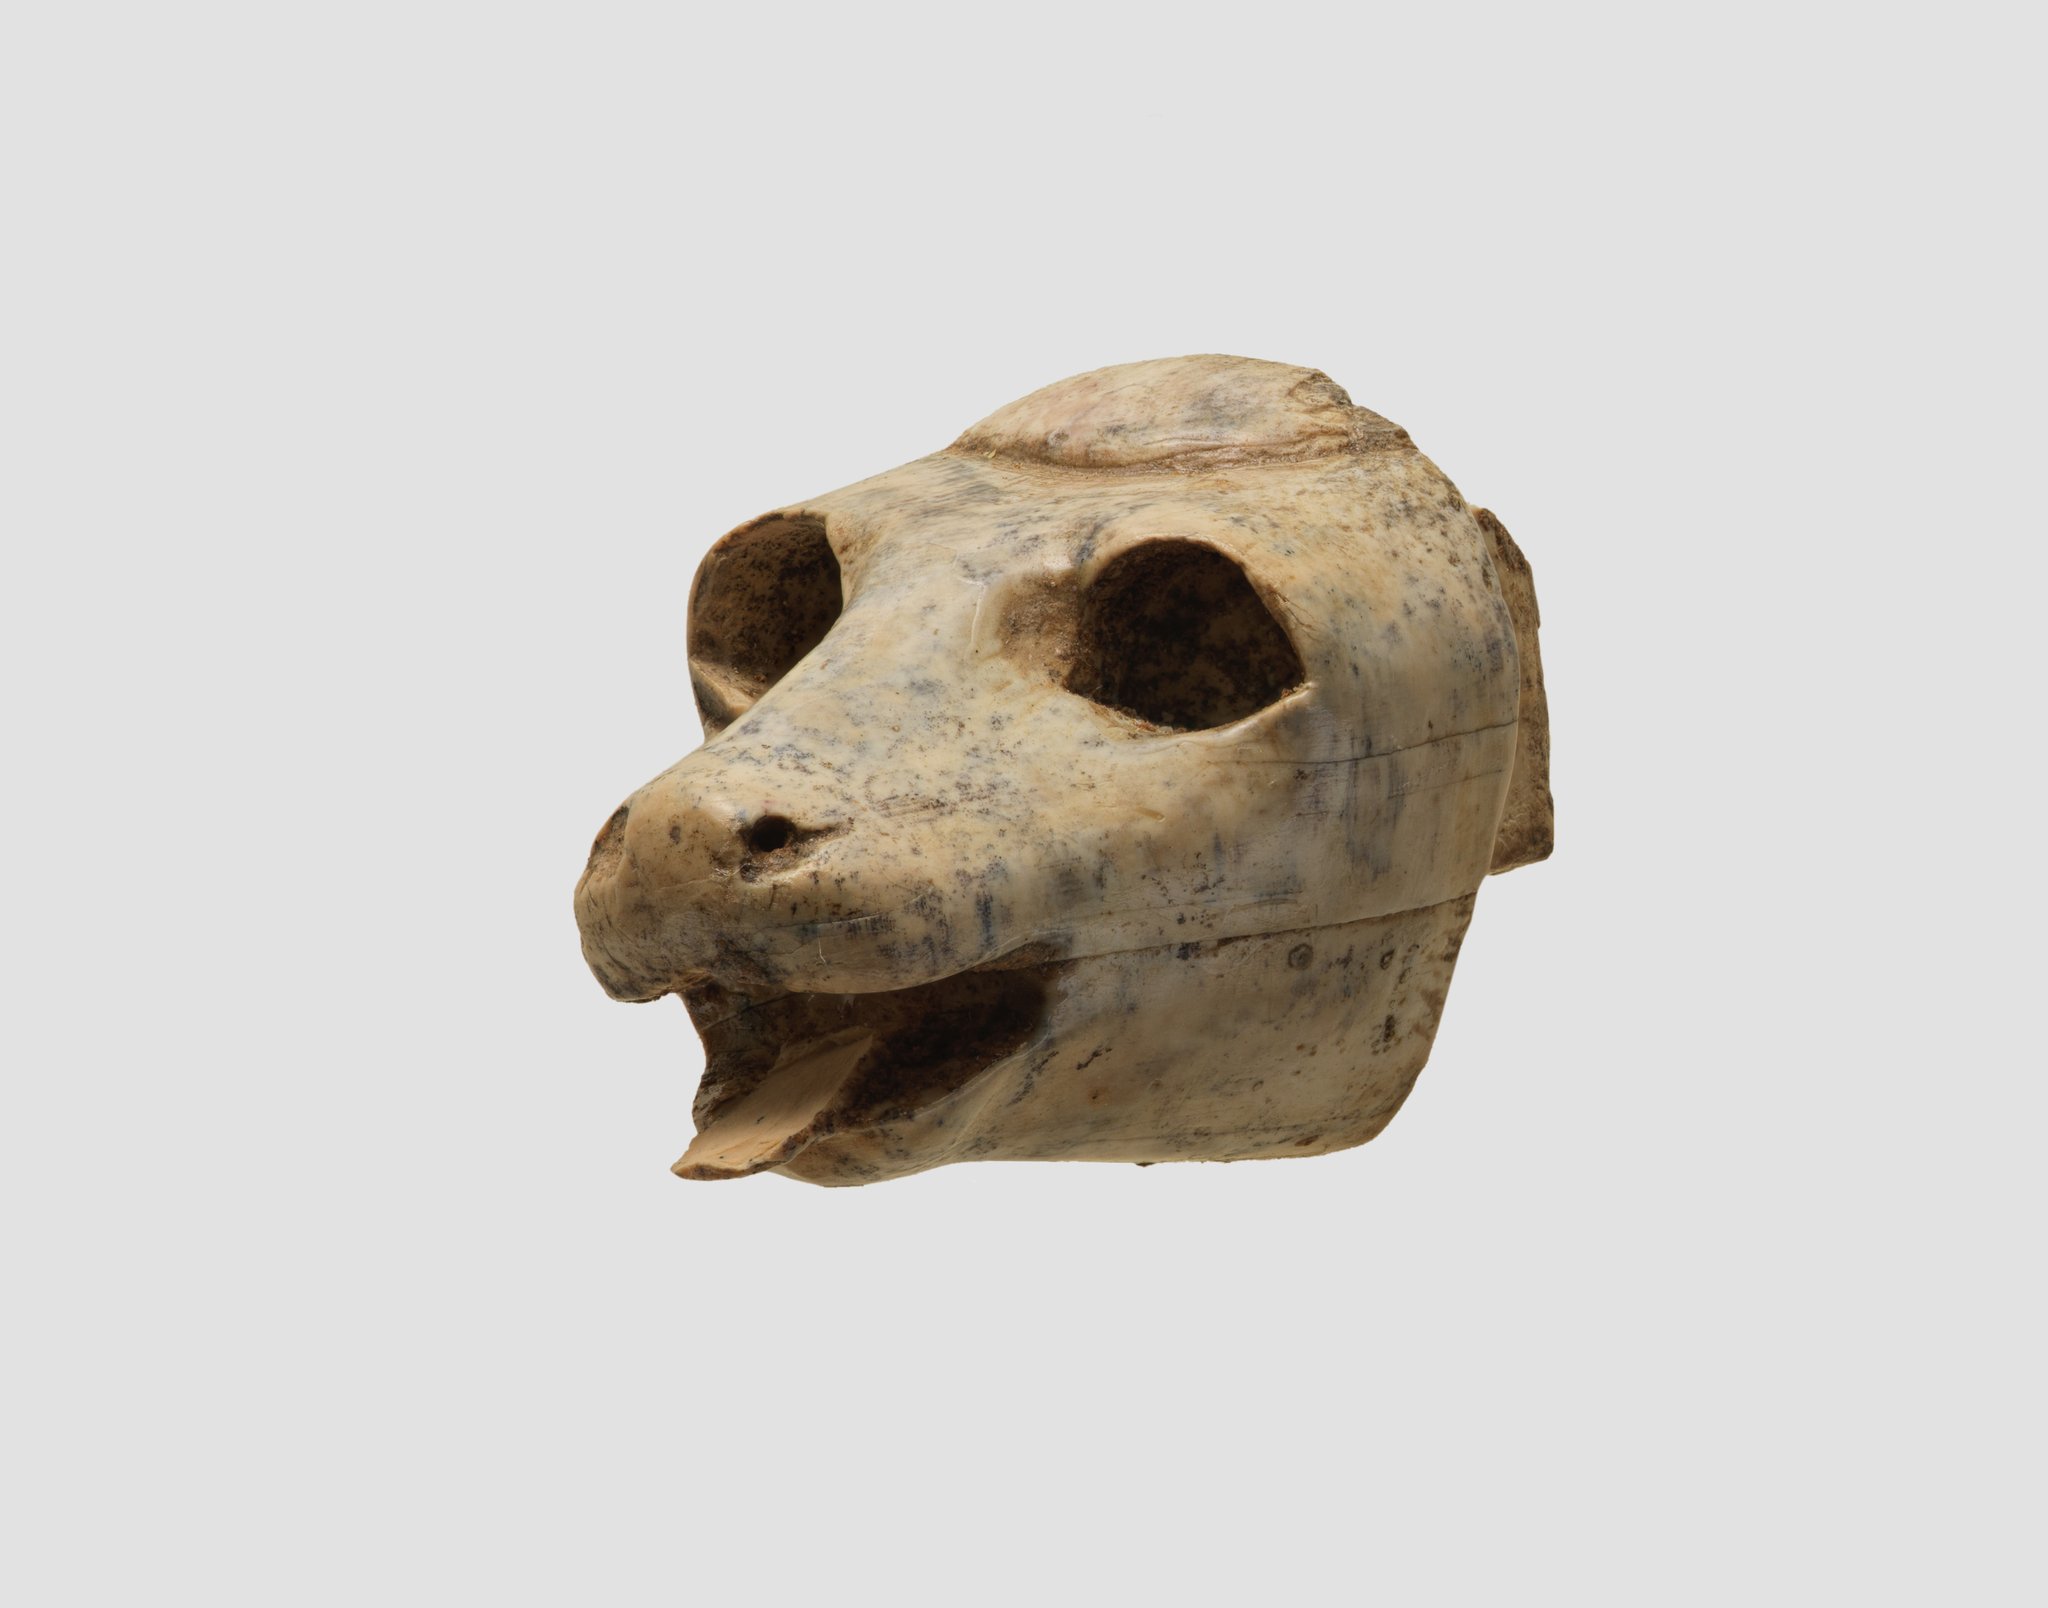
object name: furniture element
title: Animal head carved in the round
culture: assyrian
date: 800-601 BCE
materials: ivory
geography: mesopotamia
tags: dogs